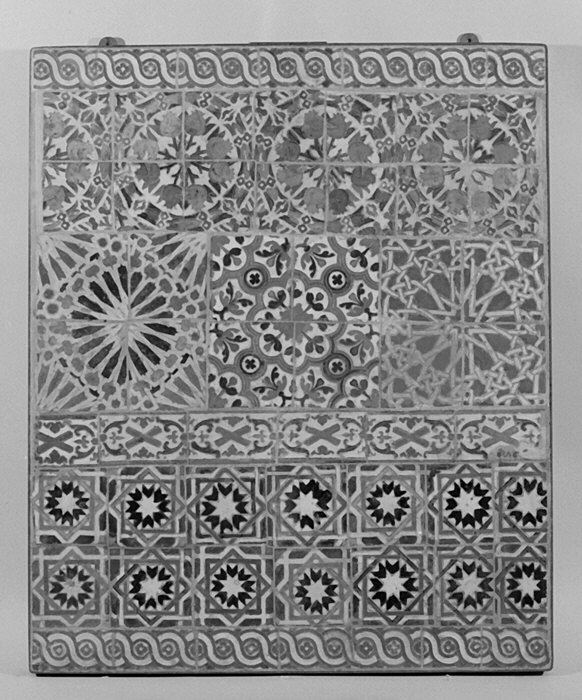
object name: tile panel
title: Panel of tiles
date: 1401-1600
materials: earthenware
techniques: glazing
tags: flowers